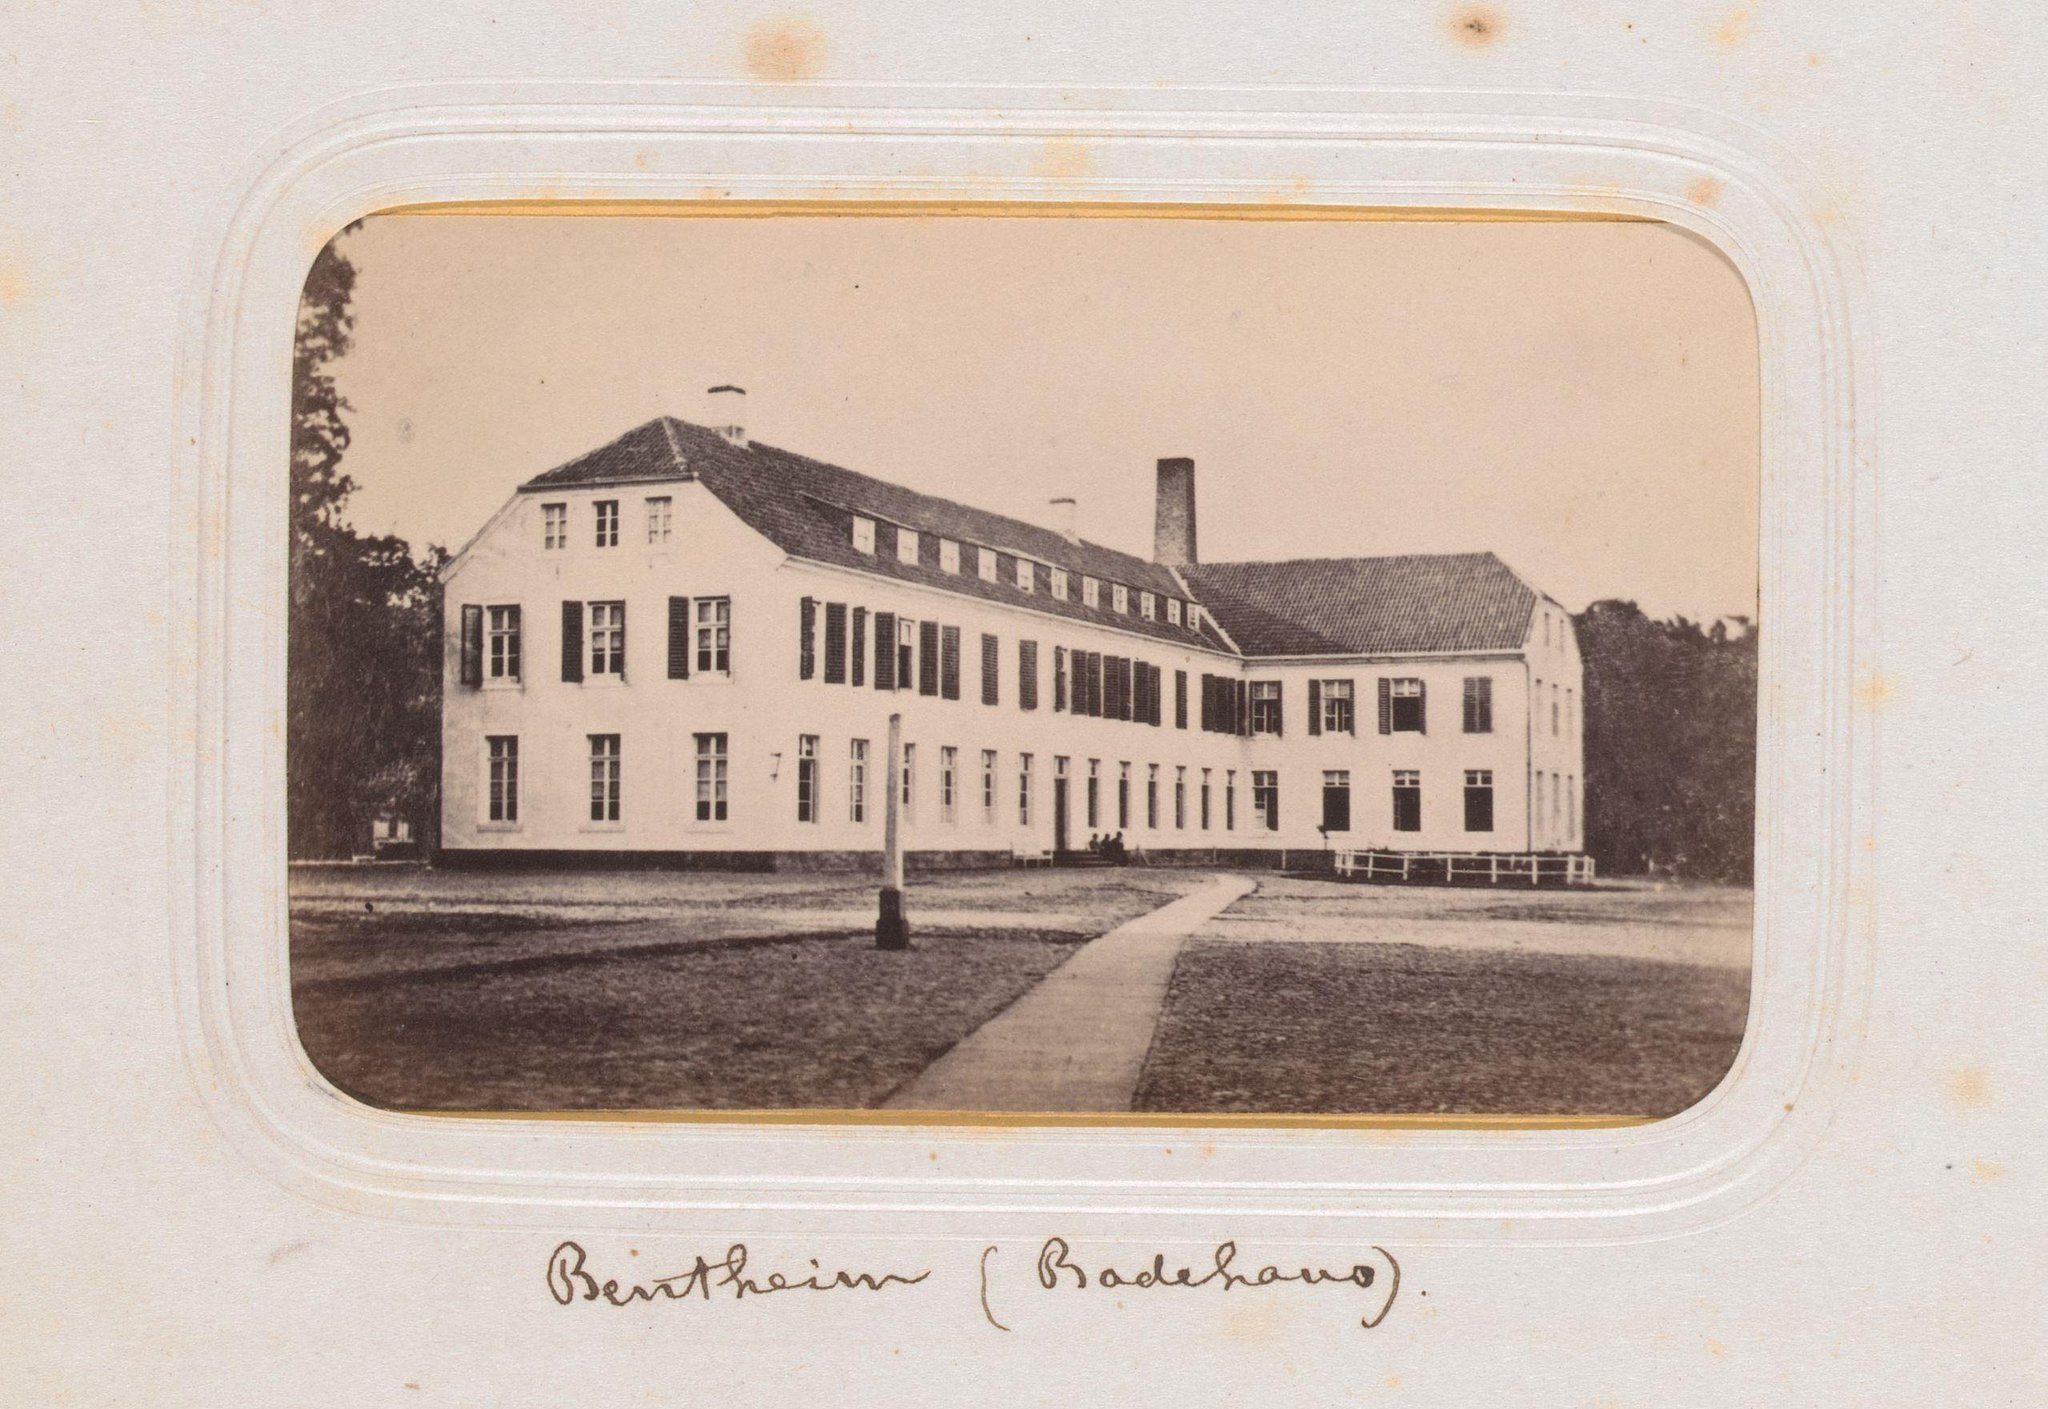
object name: carte de visite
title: Exterieur van het badhuis van Bentheim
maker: Anonymous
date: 1871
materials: cardboard, paper, photographic support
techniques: albumen print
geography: bentheim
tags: watering-place, spa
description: Onderdeel van Reisalbum met foto's van bezienswaardigheden in Zwitserland.